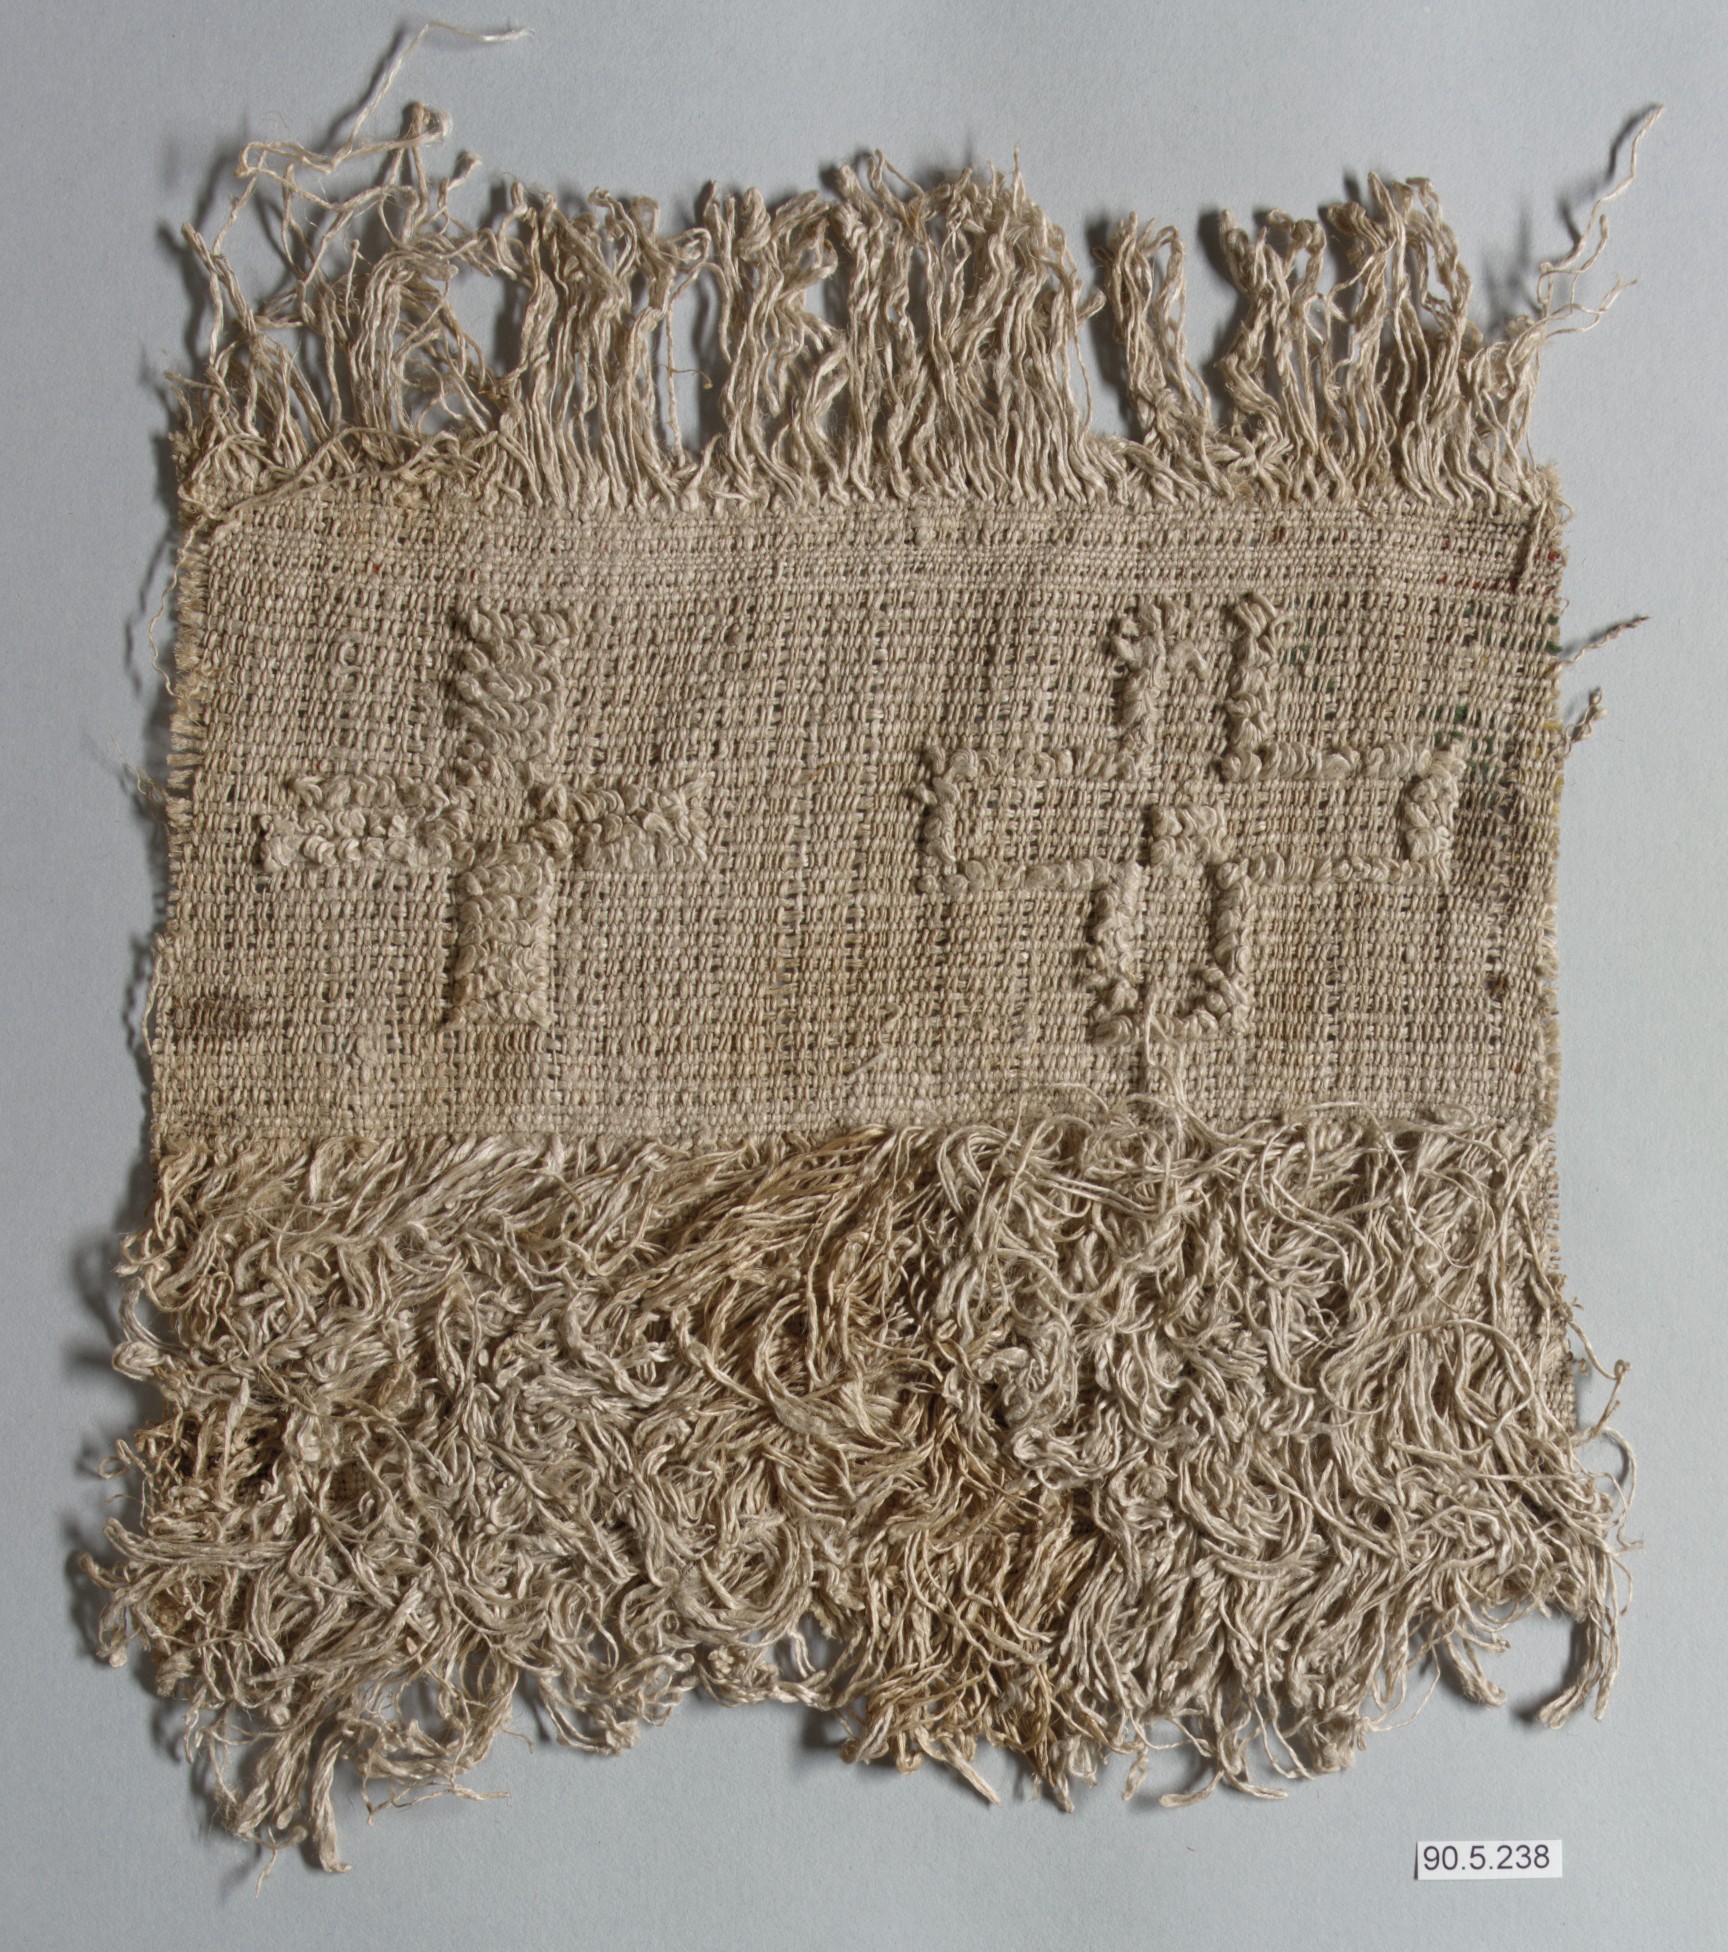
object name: textile fragment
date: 301-500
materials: linen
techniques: weave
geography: egypt